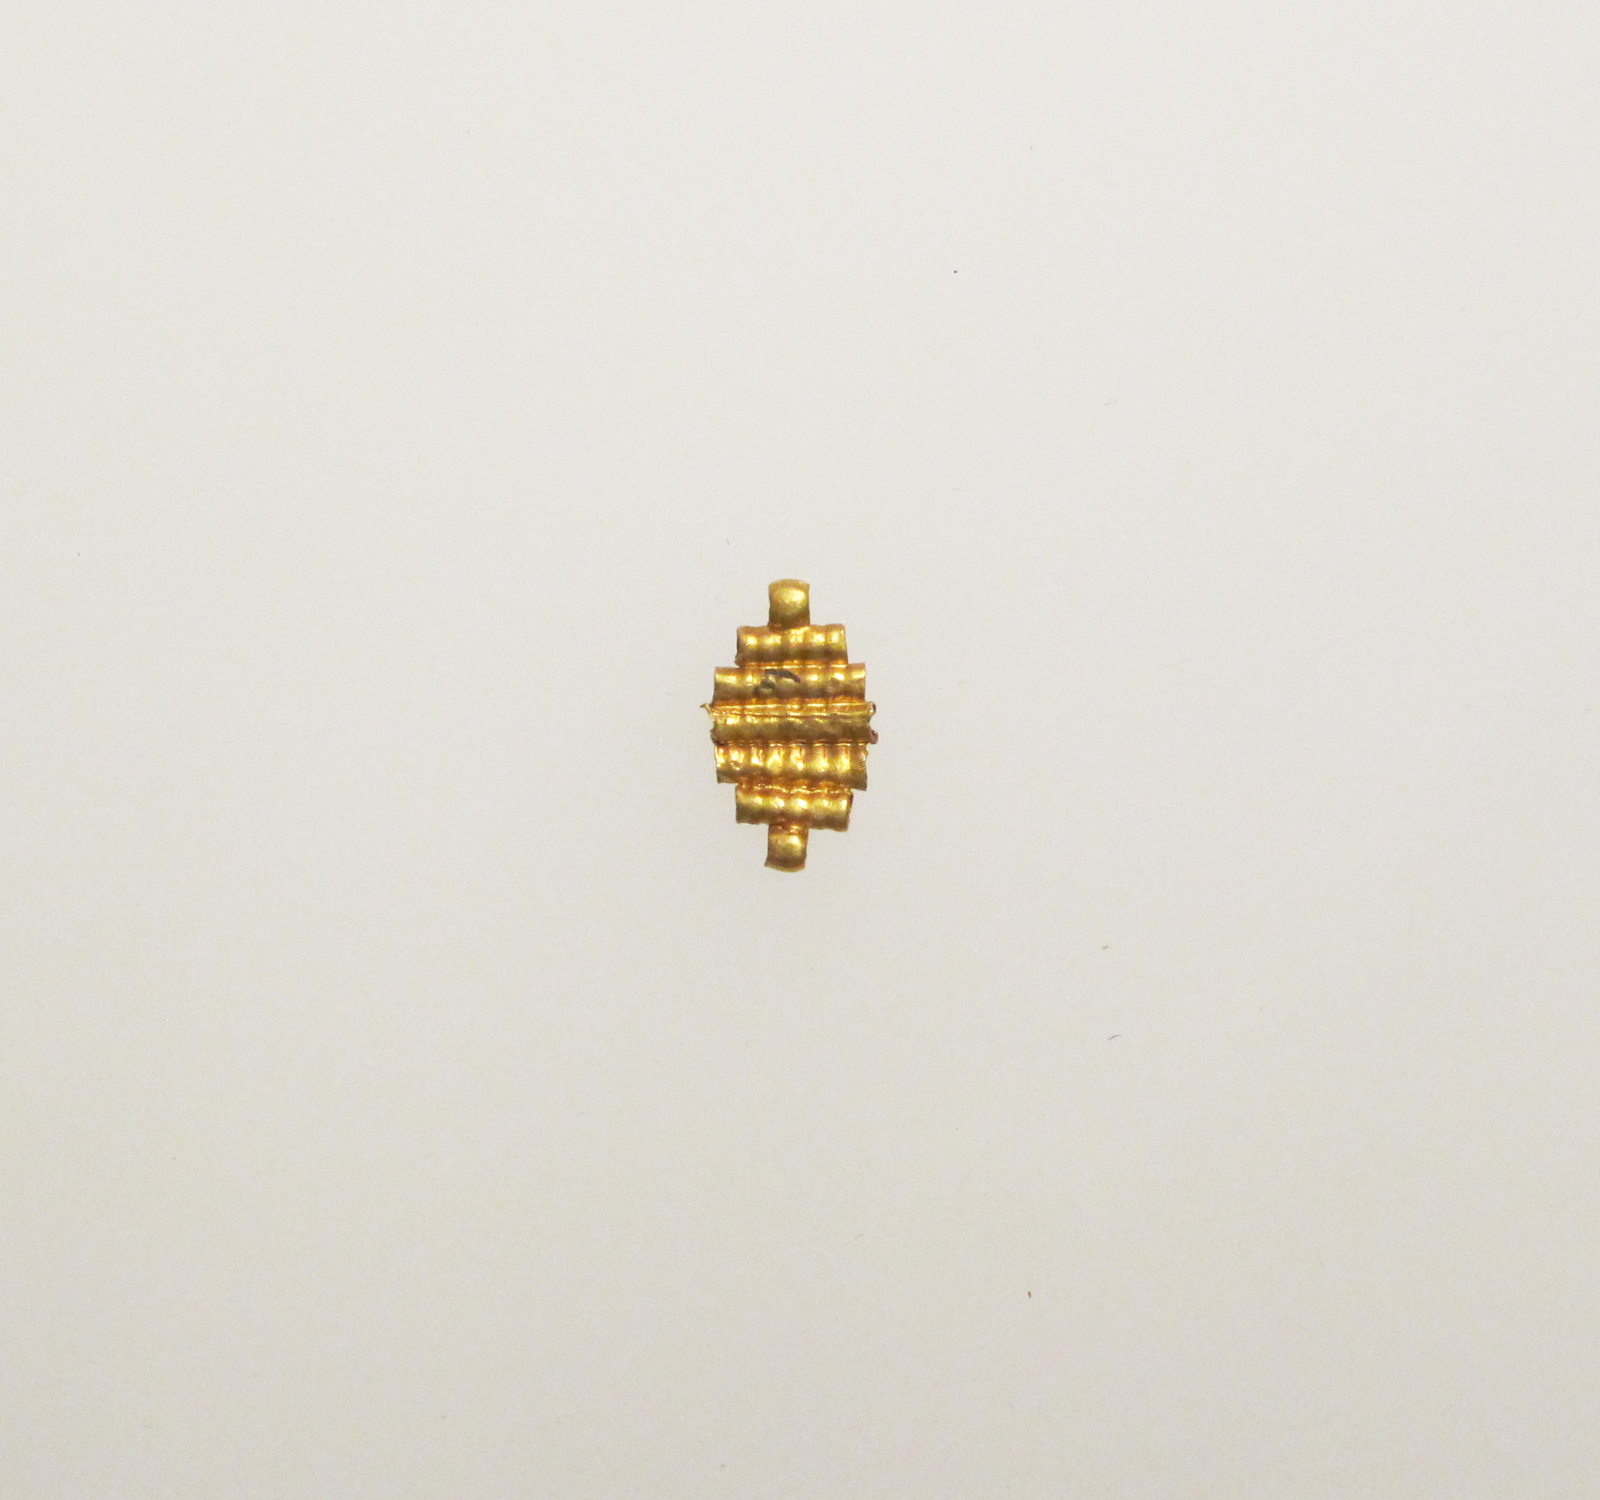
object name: bead ornament, oval shaped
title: Bead ornament, oval-shaped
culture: roman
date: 201-300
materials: gold